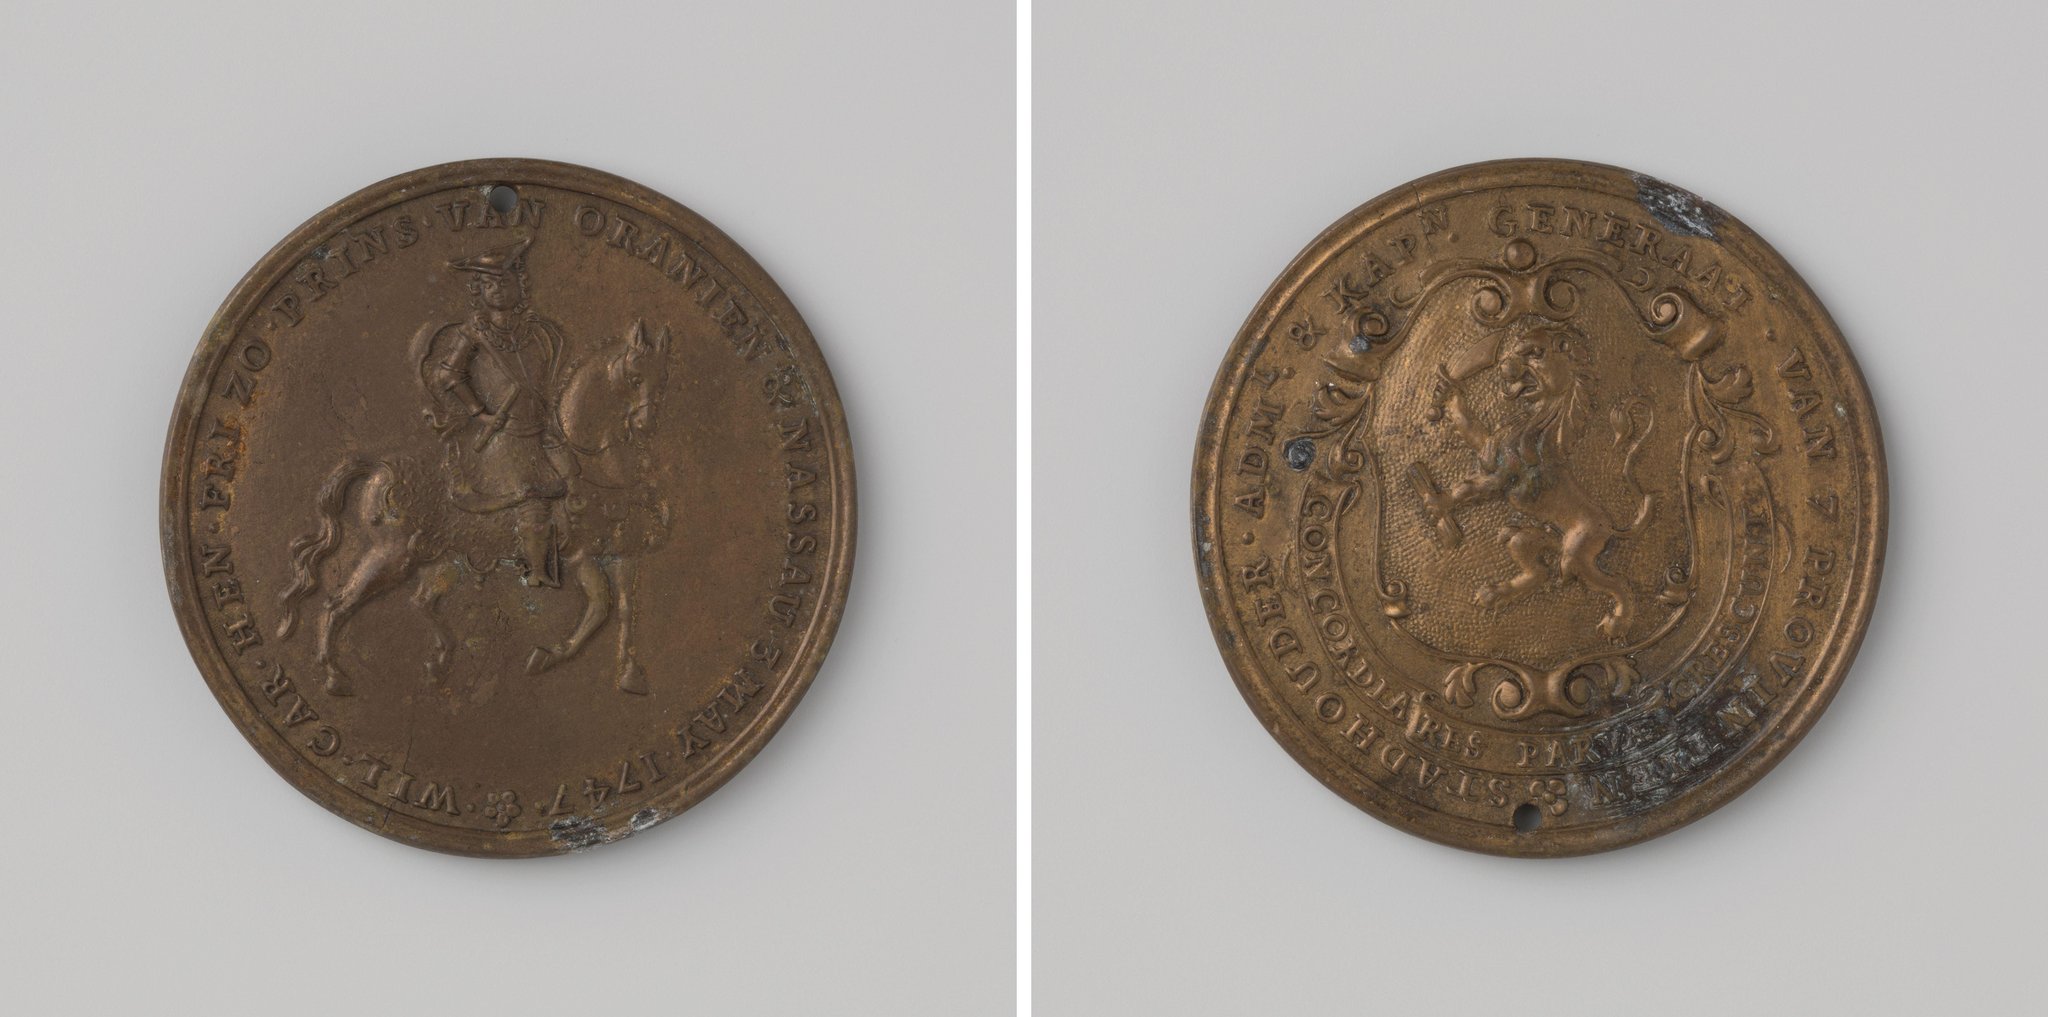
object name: history medal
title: Verheffing van Willem IV, prins van Oranje-Nassau, tot admiraal en kapitein-generaal der Verenigde Nederlanden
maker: Anonymous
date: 1747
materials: copper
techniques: striking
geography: netherlands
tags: willem iv (prins van oranje-nassau)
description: Koperen penning met gat erin. Voorzijde: ruiter met commandostaf in rechterhand binnen omschrift. Keerzijde: wapenschild in versierd cartouche, omhangen met wimpel met opschrift binnen omschrift